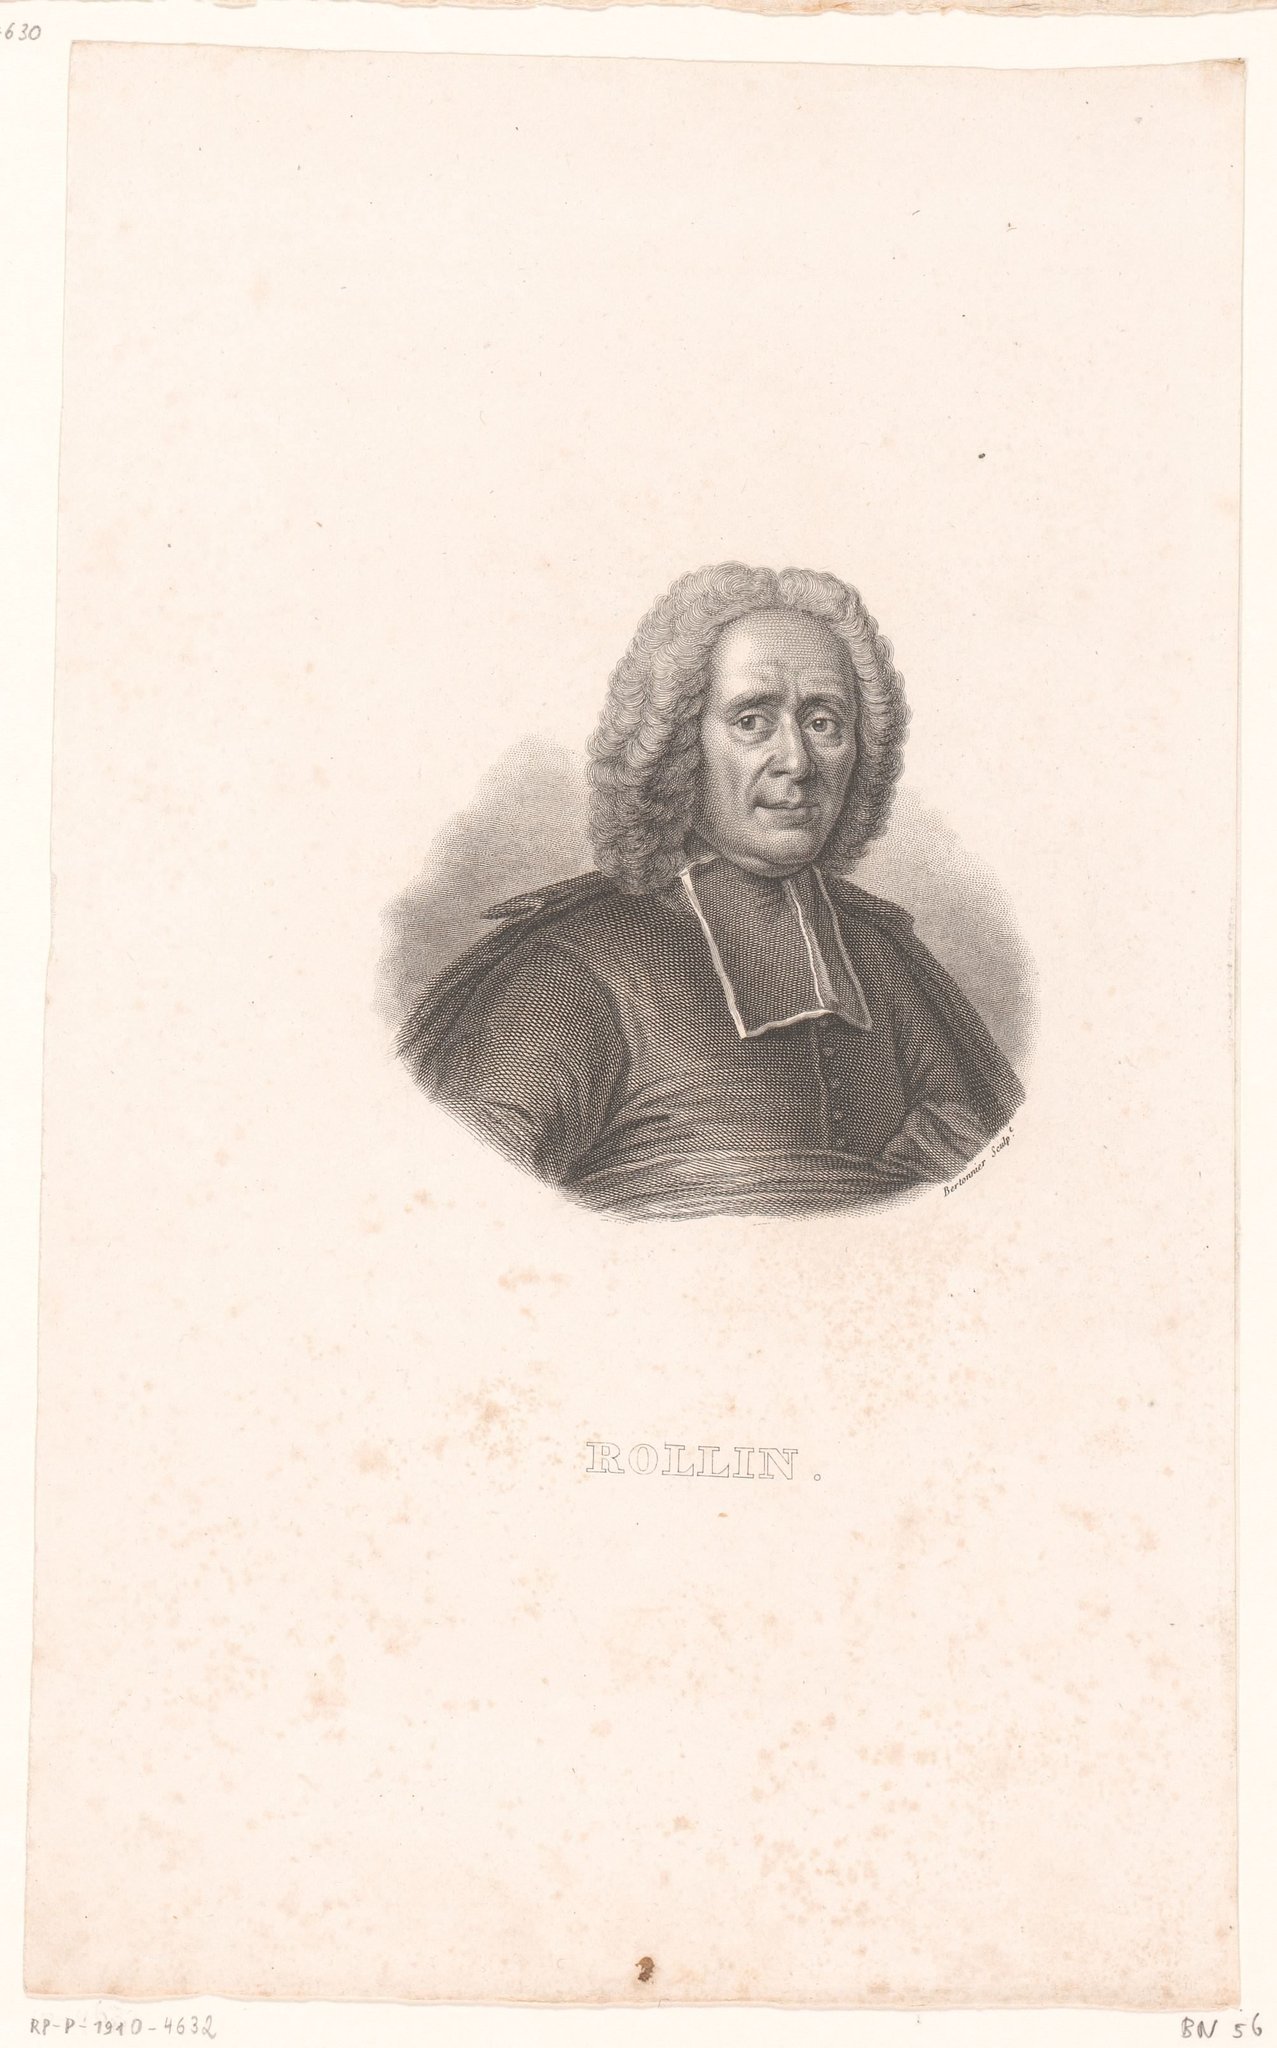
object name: print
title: Portret van Charles Rollin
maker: pierre françois bertonnier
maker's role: print maker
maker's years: 1791-1847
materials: paper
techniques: etching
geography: france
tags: paris, charles rollin, historical persons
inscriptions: collector's mark: Lugt 2228